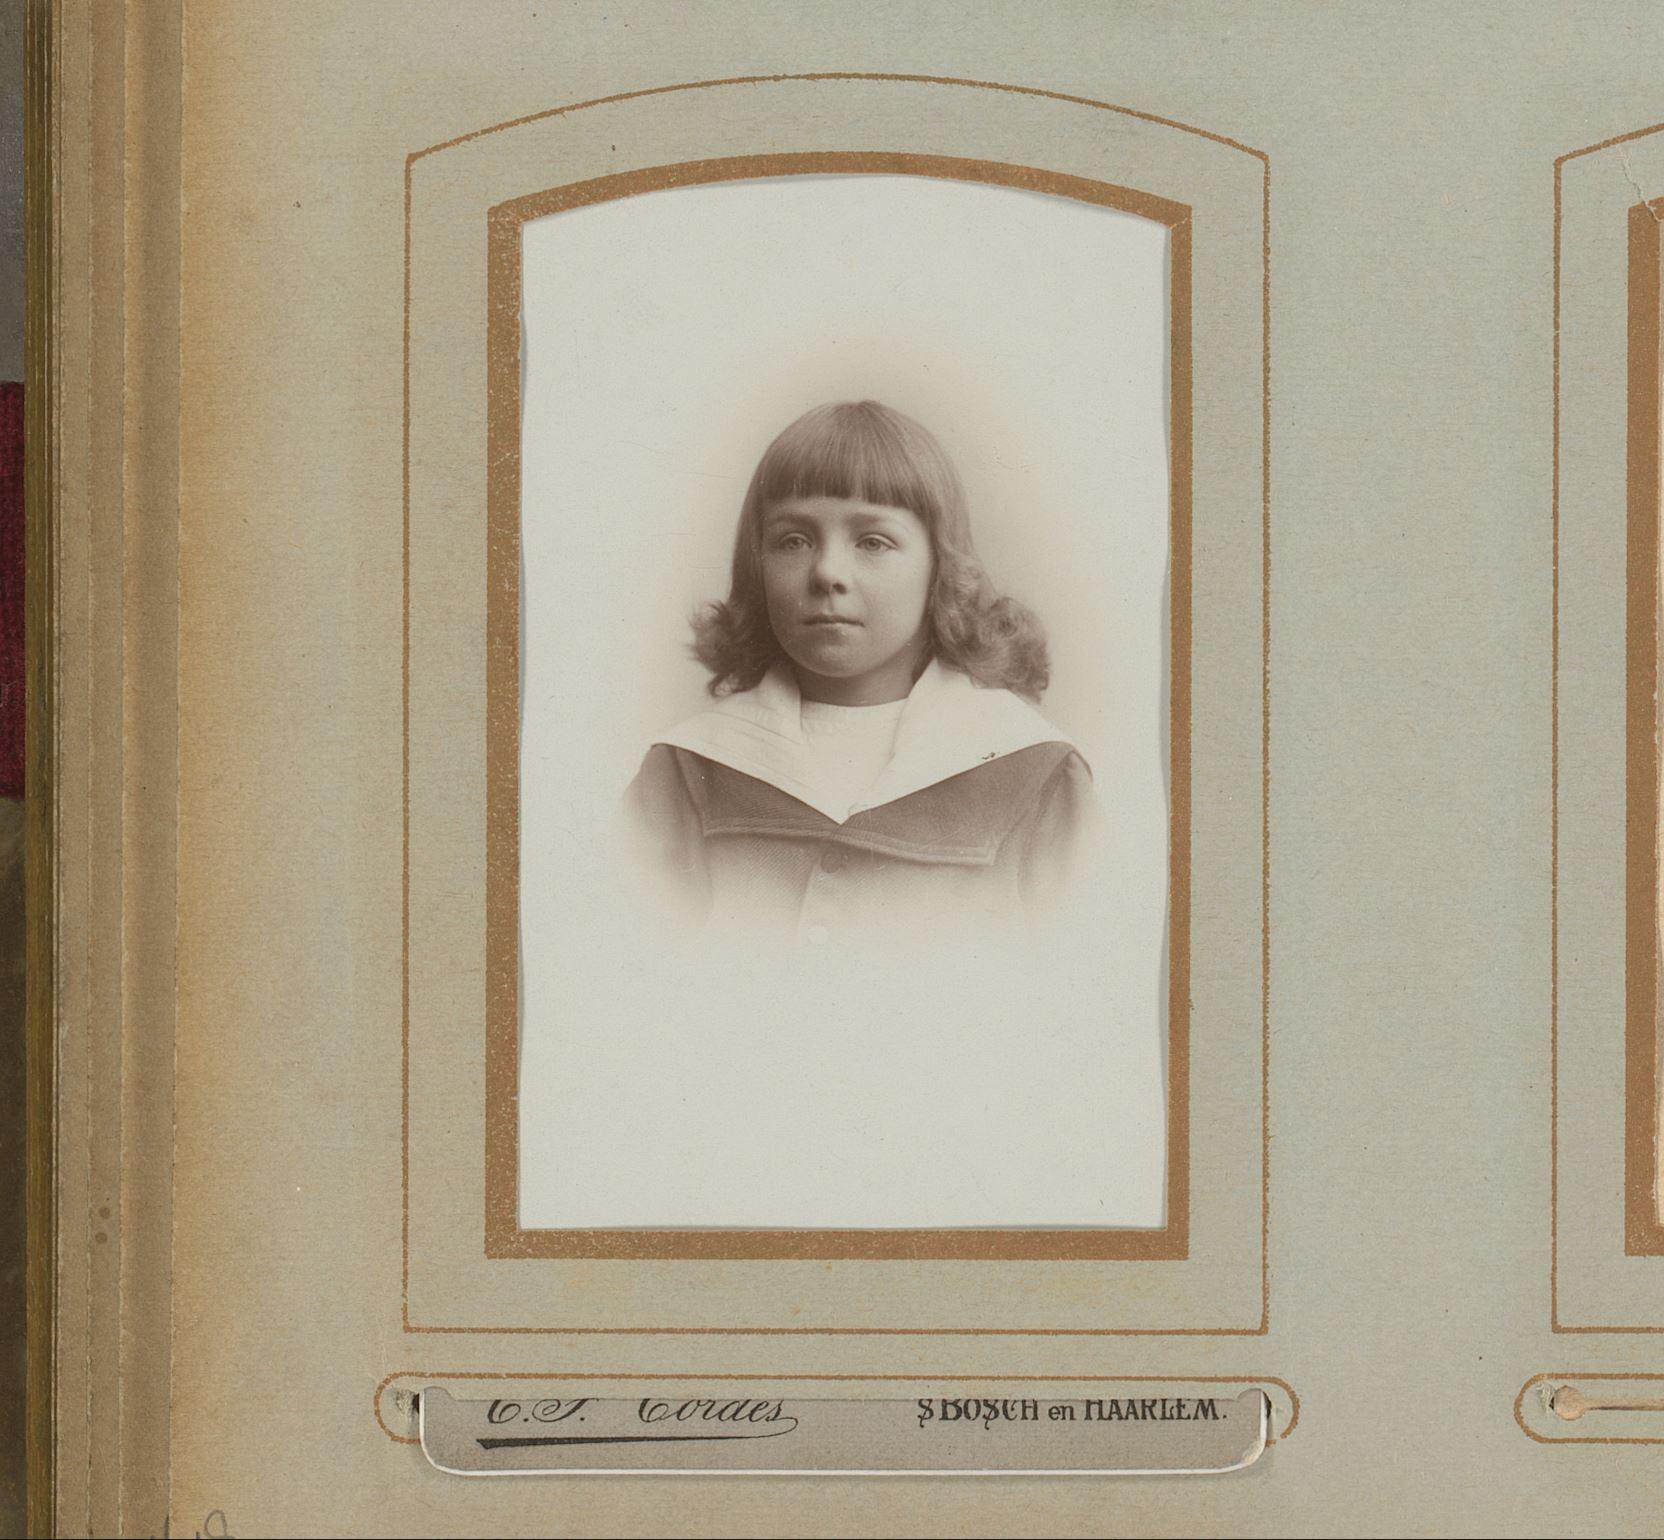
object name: photograph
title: Portret van een meisje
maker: carel frederik cordes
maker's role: fotograaf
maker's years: 1851-1927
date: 1882-1927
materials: cardboard, photographic support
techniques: collodion silver print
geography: amsterdam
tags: girl (child between toddler and youth)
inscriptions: inscription: ‘Photogr. Inrichting/ C.F. Cordes/ 's Bosch/ aan de Parade/ Haarlem, Groote Houtstraat 84’